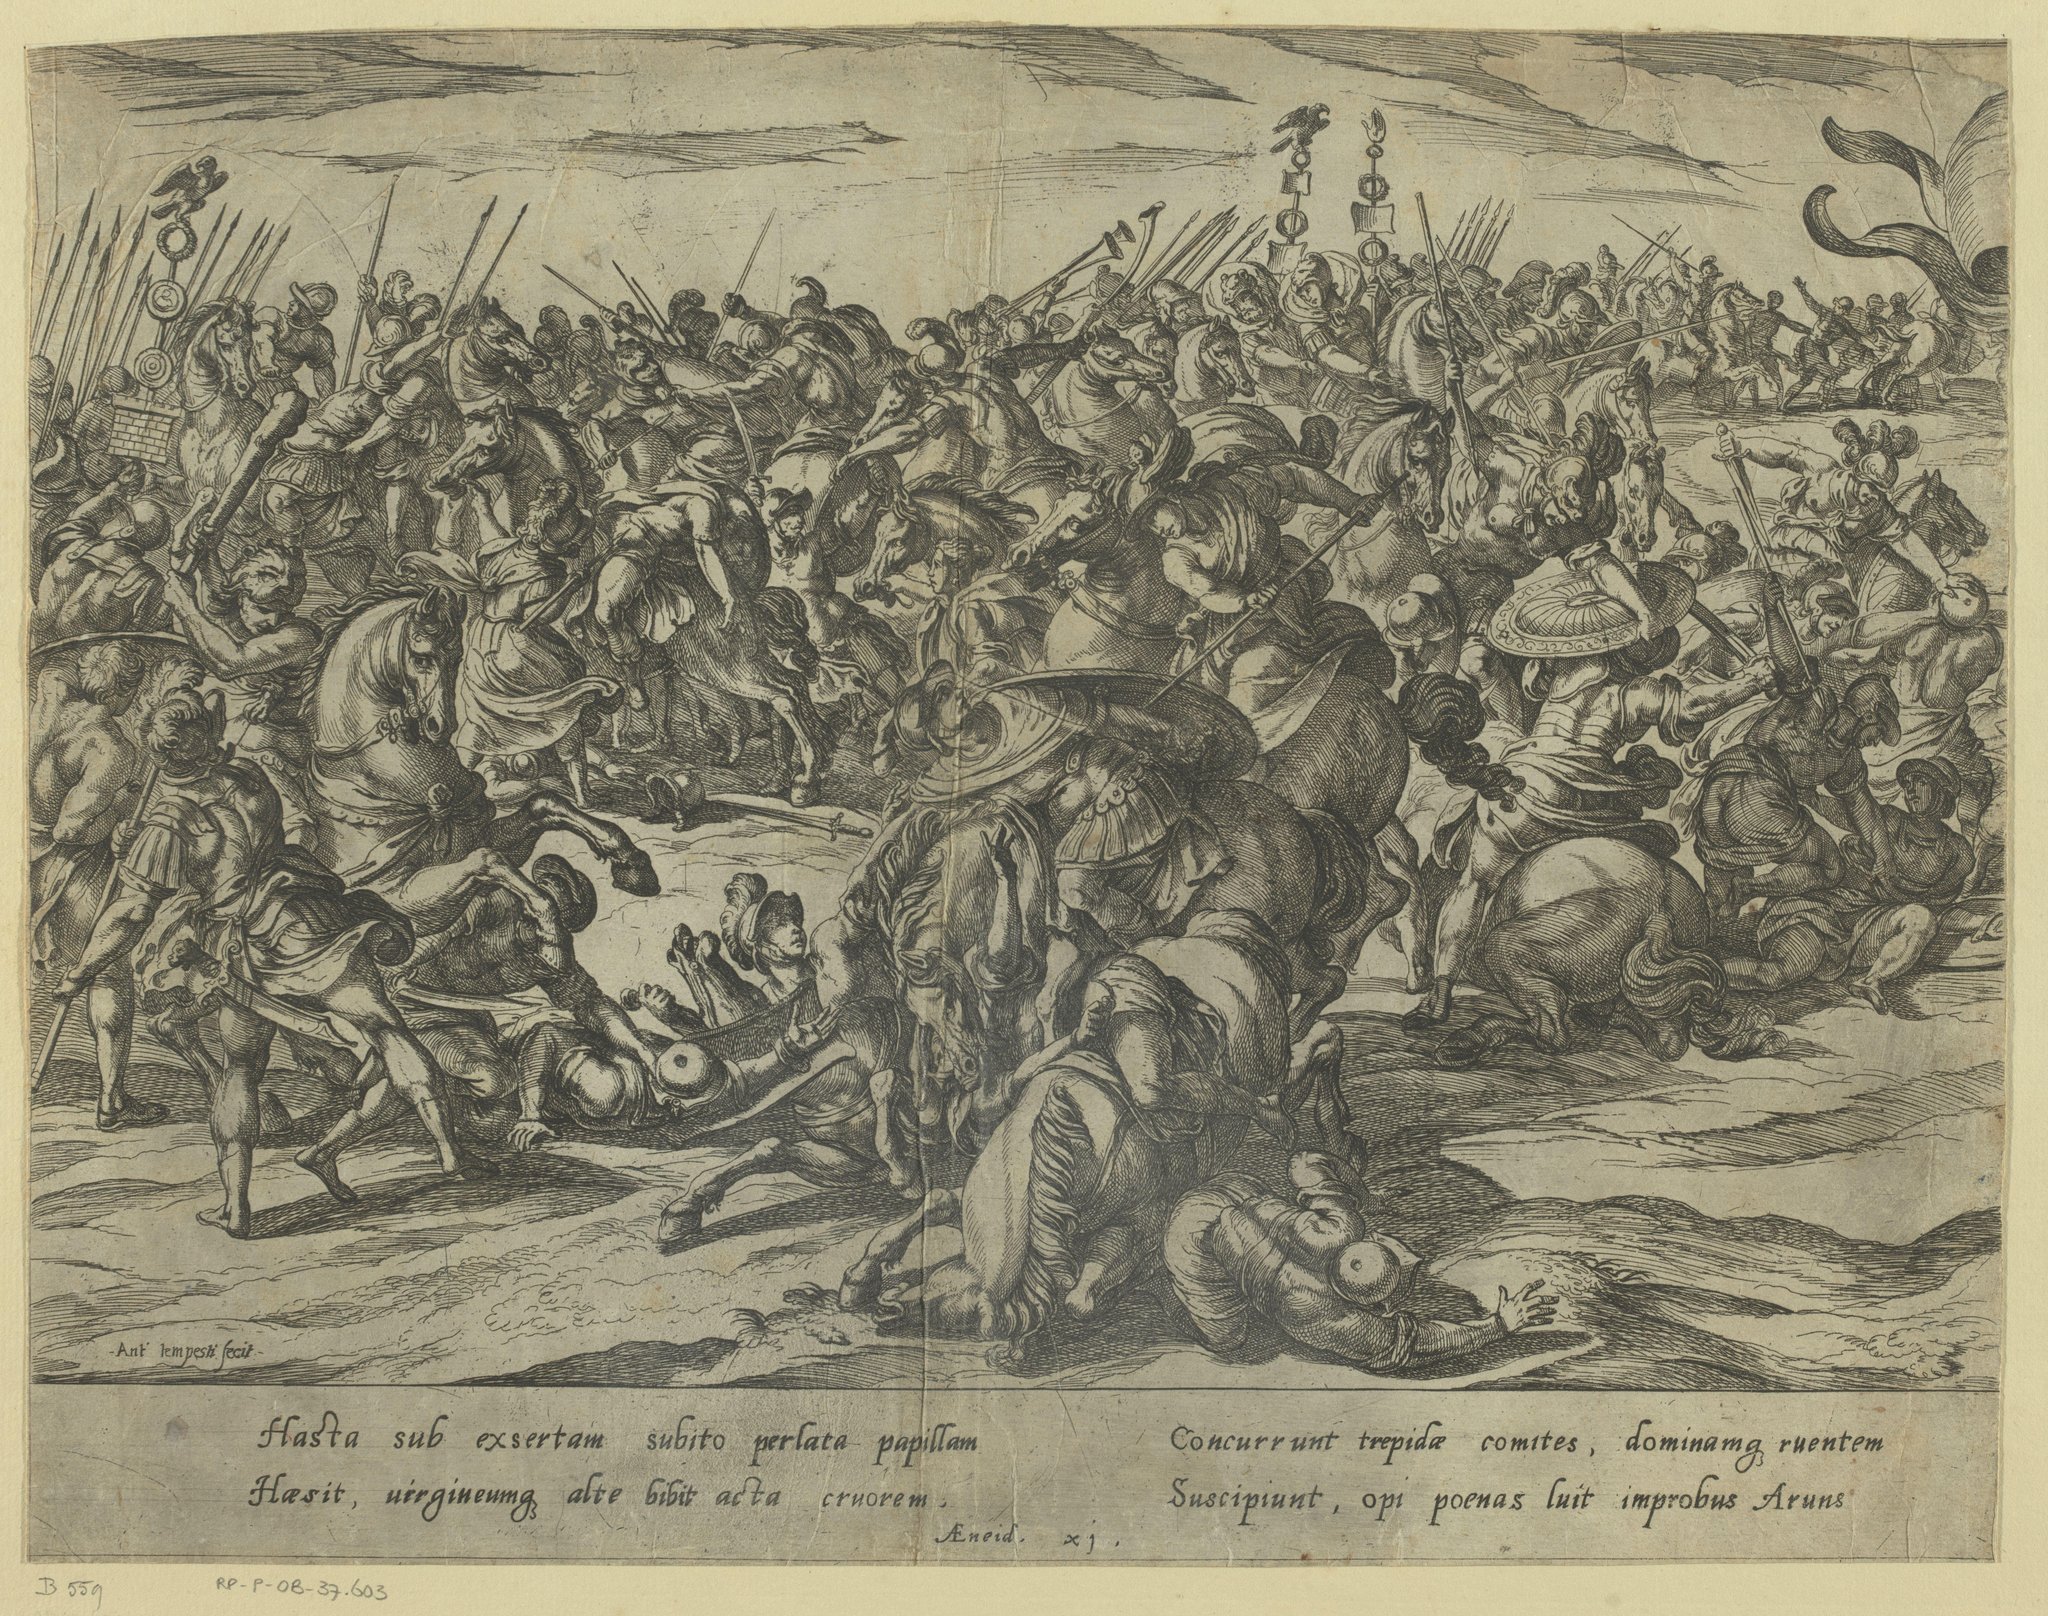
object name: print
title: De dood van Camillus in de strijd tussen Grieken en Romeinen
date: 1591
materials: paper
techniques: etching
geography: rome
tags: (story of) camilla - death, battle, the soldier; the soldier's life, warfare; military affairs (+ land forces)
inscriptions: collector's mark: Lugt 240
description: De dood van Camillus in een strijdgewoel van Griekse en Romeinse soldaten te paard. Vers in het Latijn in ondermarge.